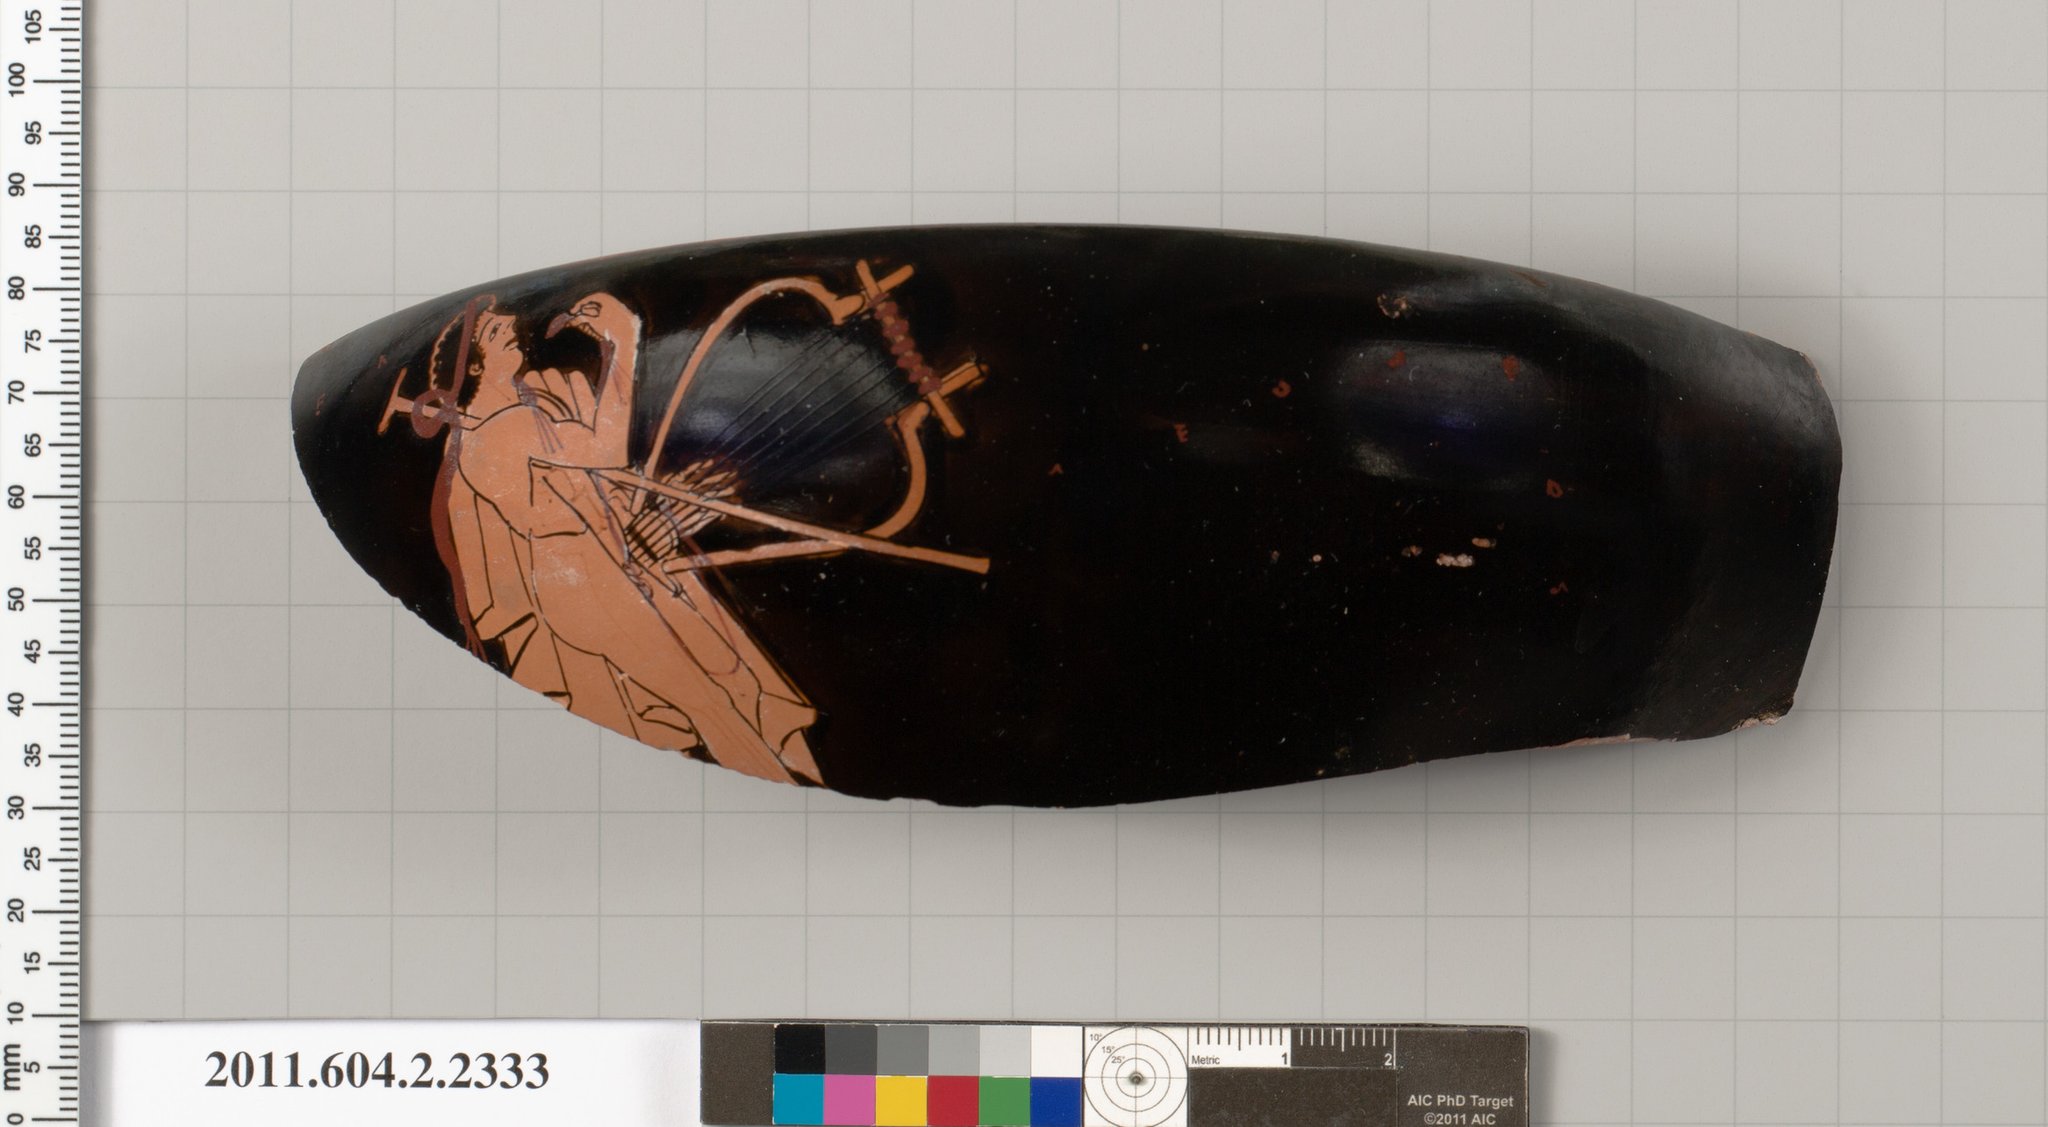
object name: skyphos fragment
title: Terracotta fragment of a skyphos (deep drinking cup)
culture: greek, attic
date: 500-480 BCE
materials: terracotta